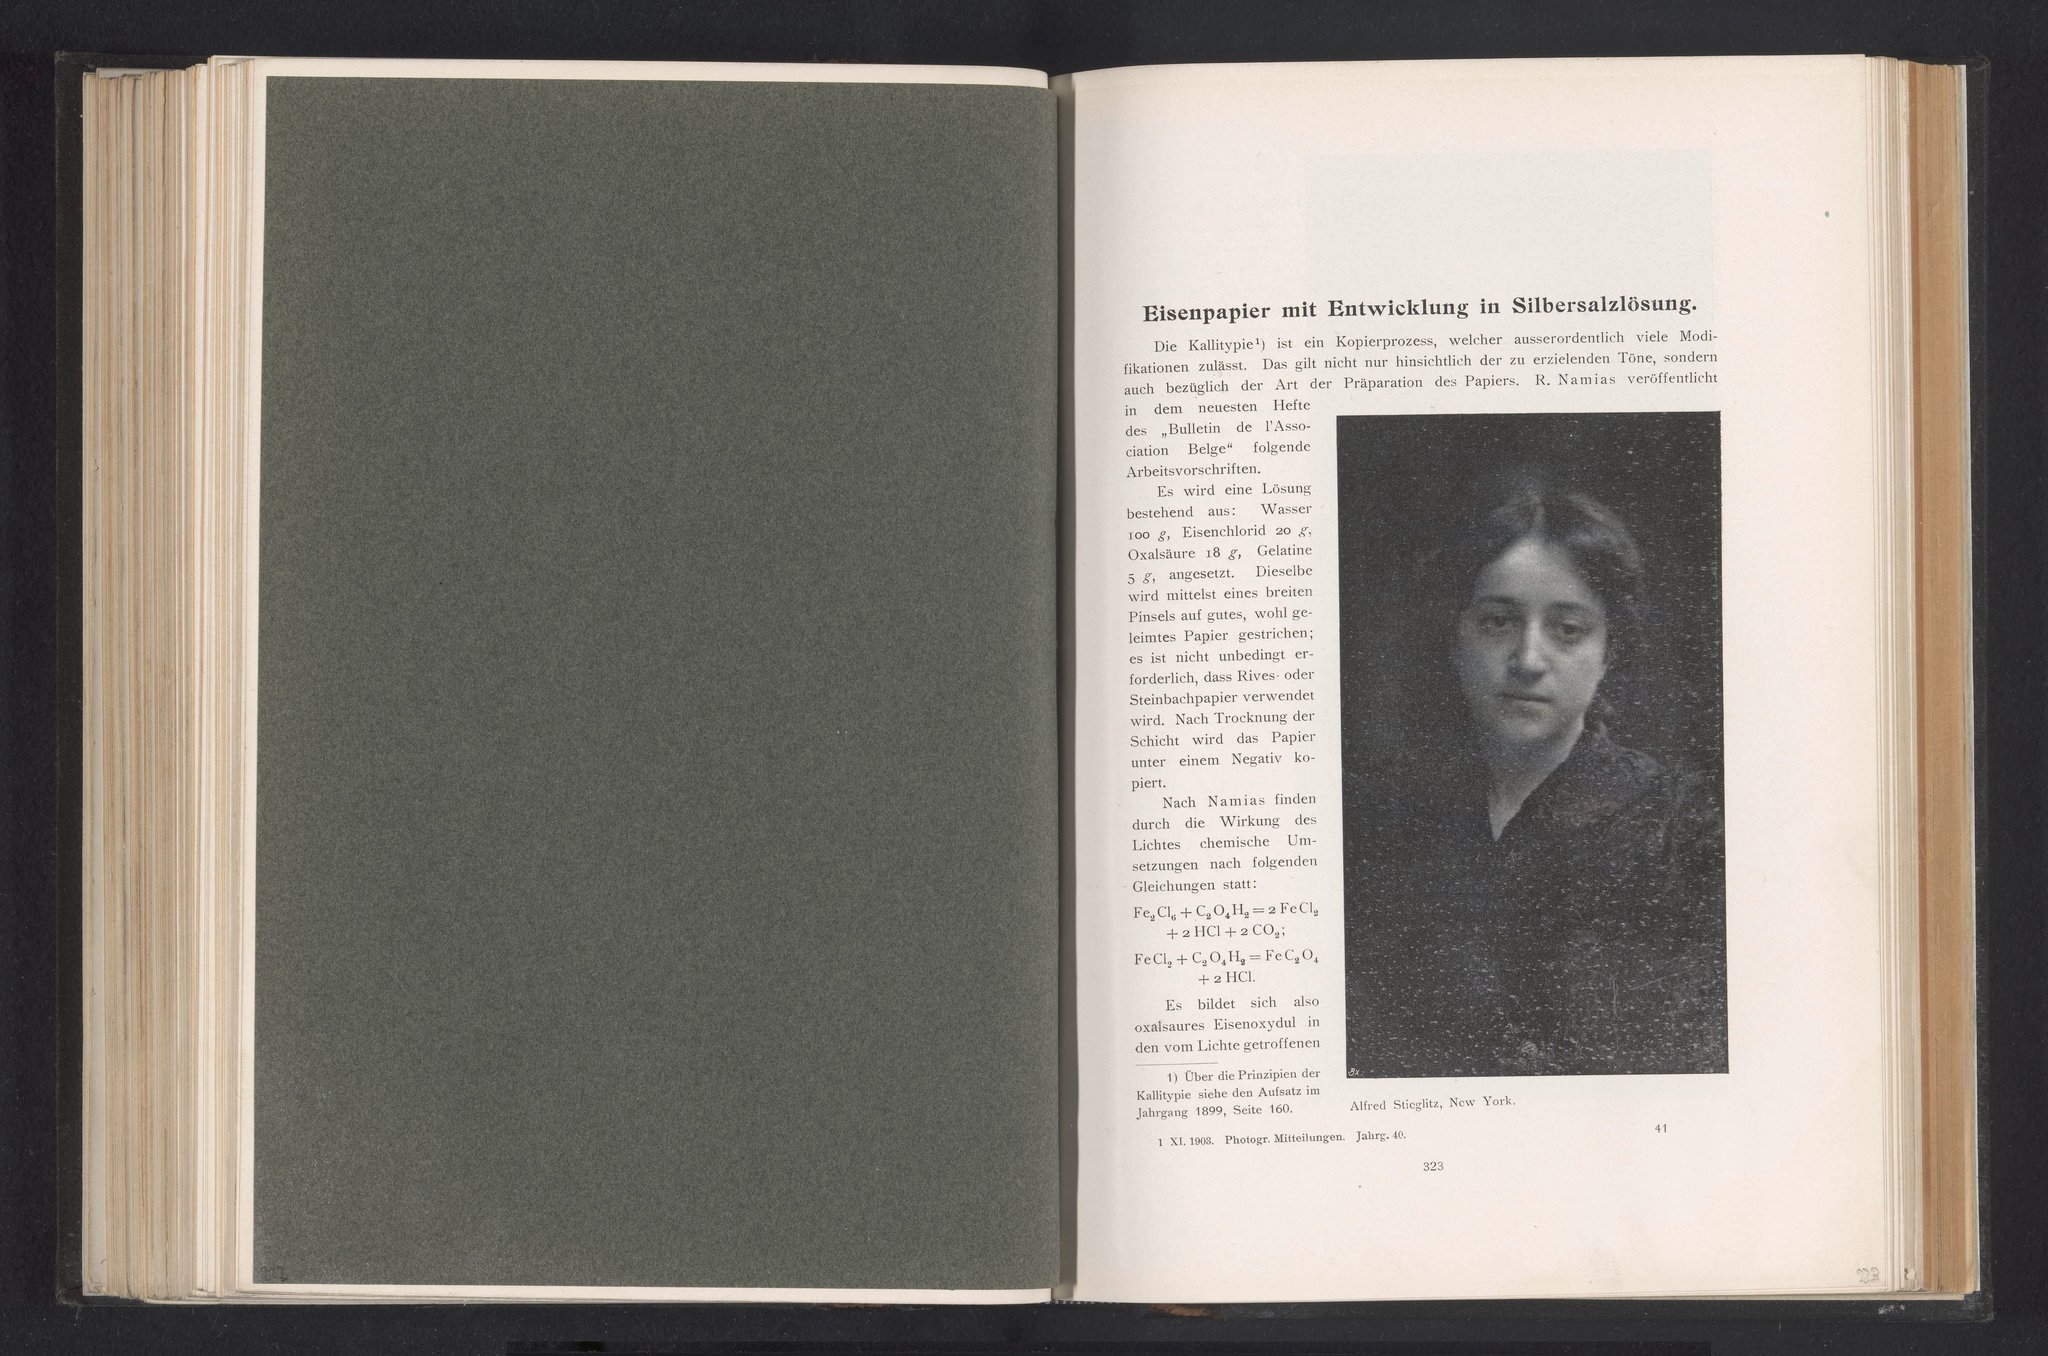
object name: page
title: Portret van een onbekende vrouw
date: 1898-1903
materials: paper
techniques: autotype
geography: new york city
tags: historical persons - bb - woman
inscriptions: monogram: ‘BX’